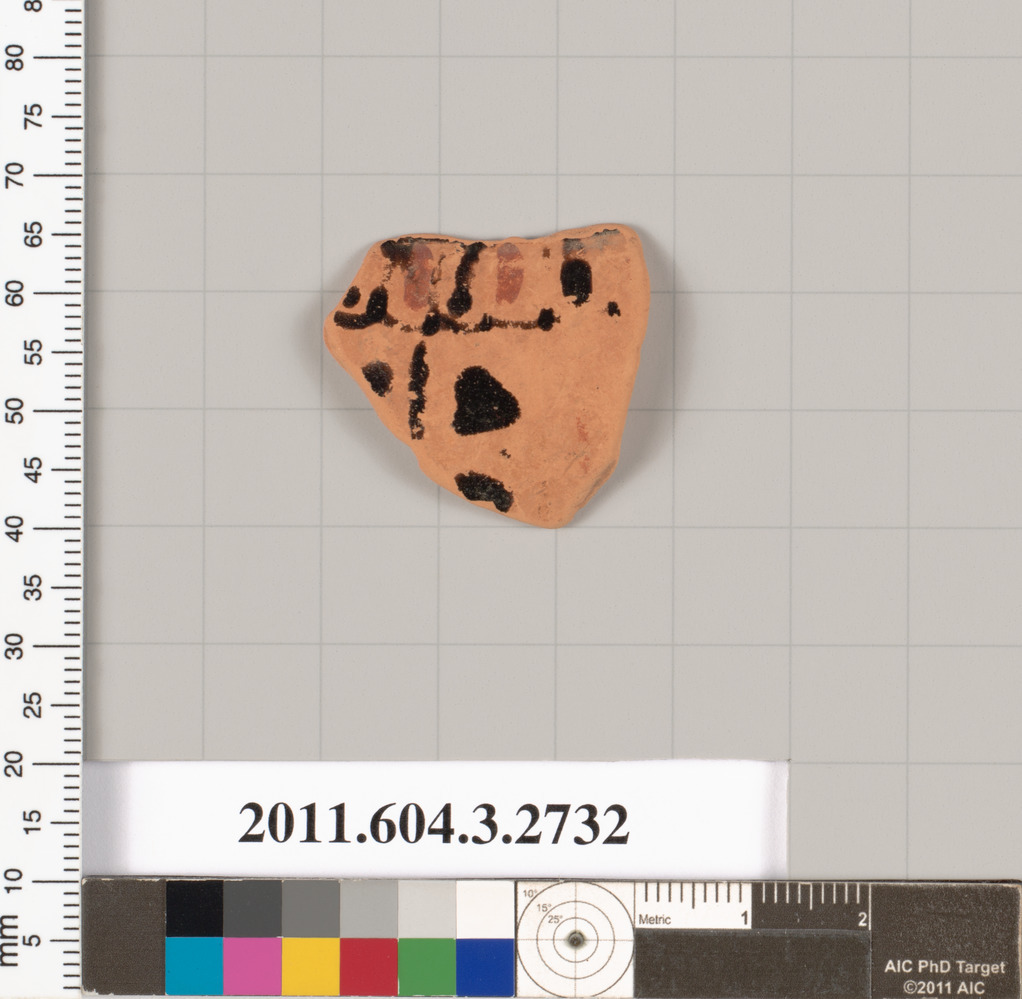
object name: oinochoe fragment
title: Terracotta fragment of an oinochoe (jug)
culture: greek, attic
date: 575-551 BCE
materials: terracotta